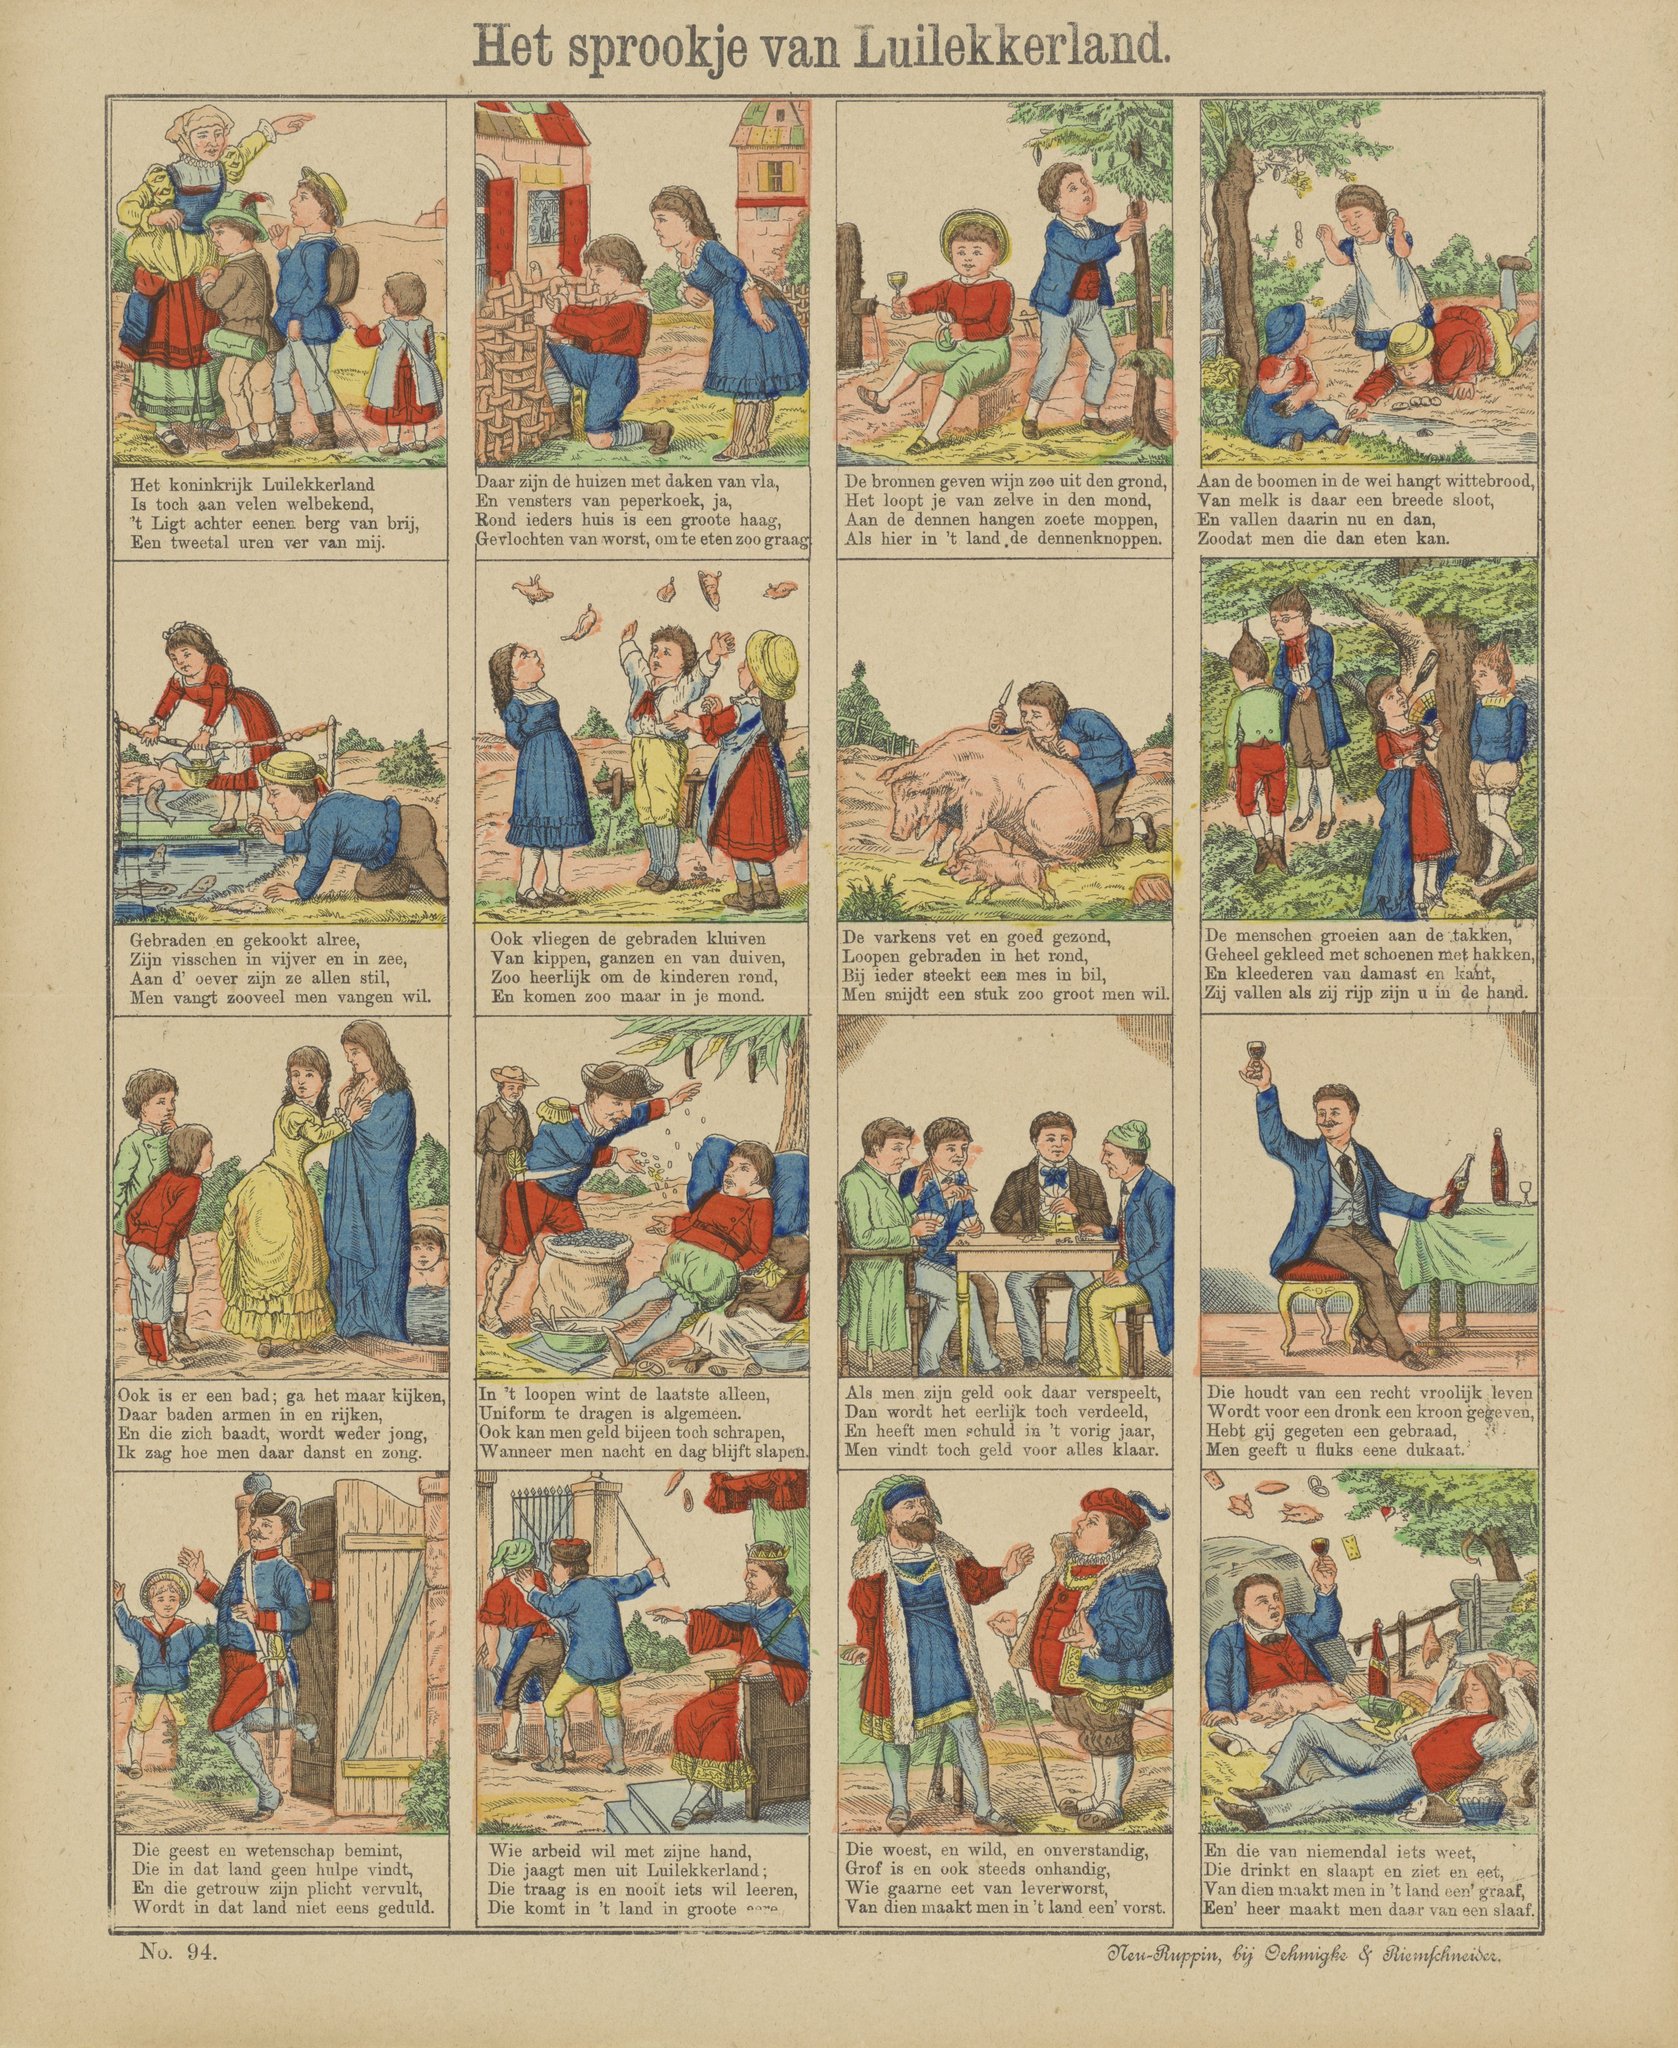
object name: popular print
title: Het sprookje van Luilekkerland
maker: Anonymous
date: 1828-1937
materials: paper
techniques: hand coloring, letterpress printing, lithograph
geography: neuruppin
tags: land of cockaigne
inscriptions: collector's mark: Lugt 2760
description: Blad met 16 voorstellingen van het Luilekkerland. Onder elke afbeelding een onderschrift. Genummerd linksonder: No. 94.